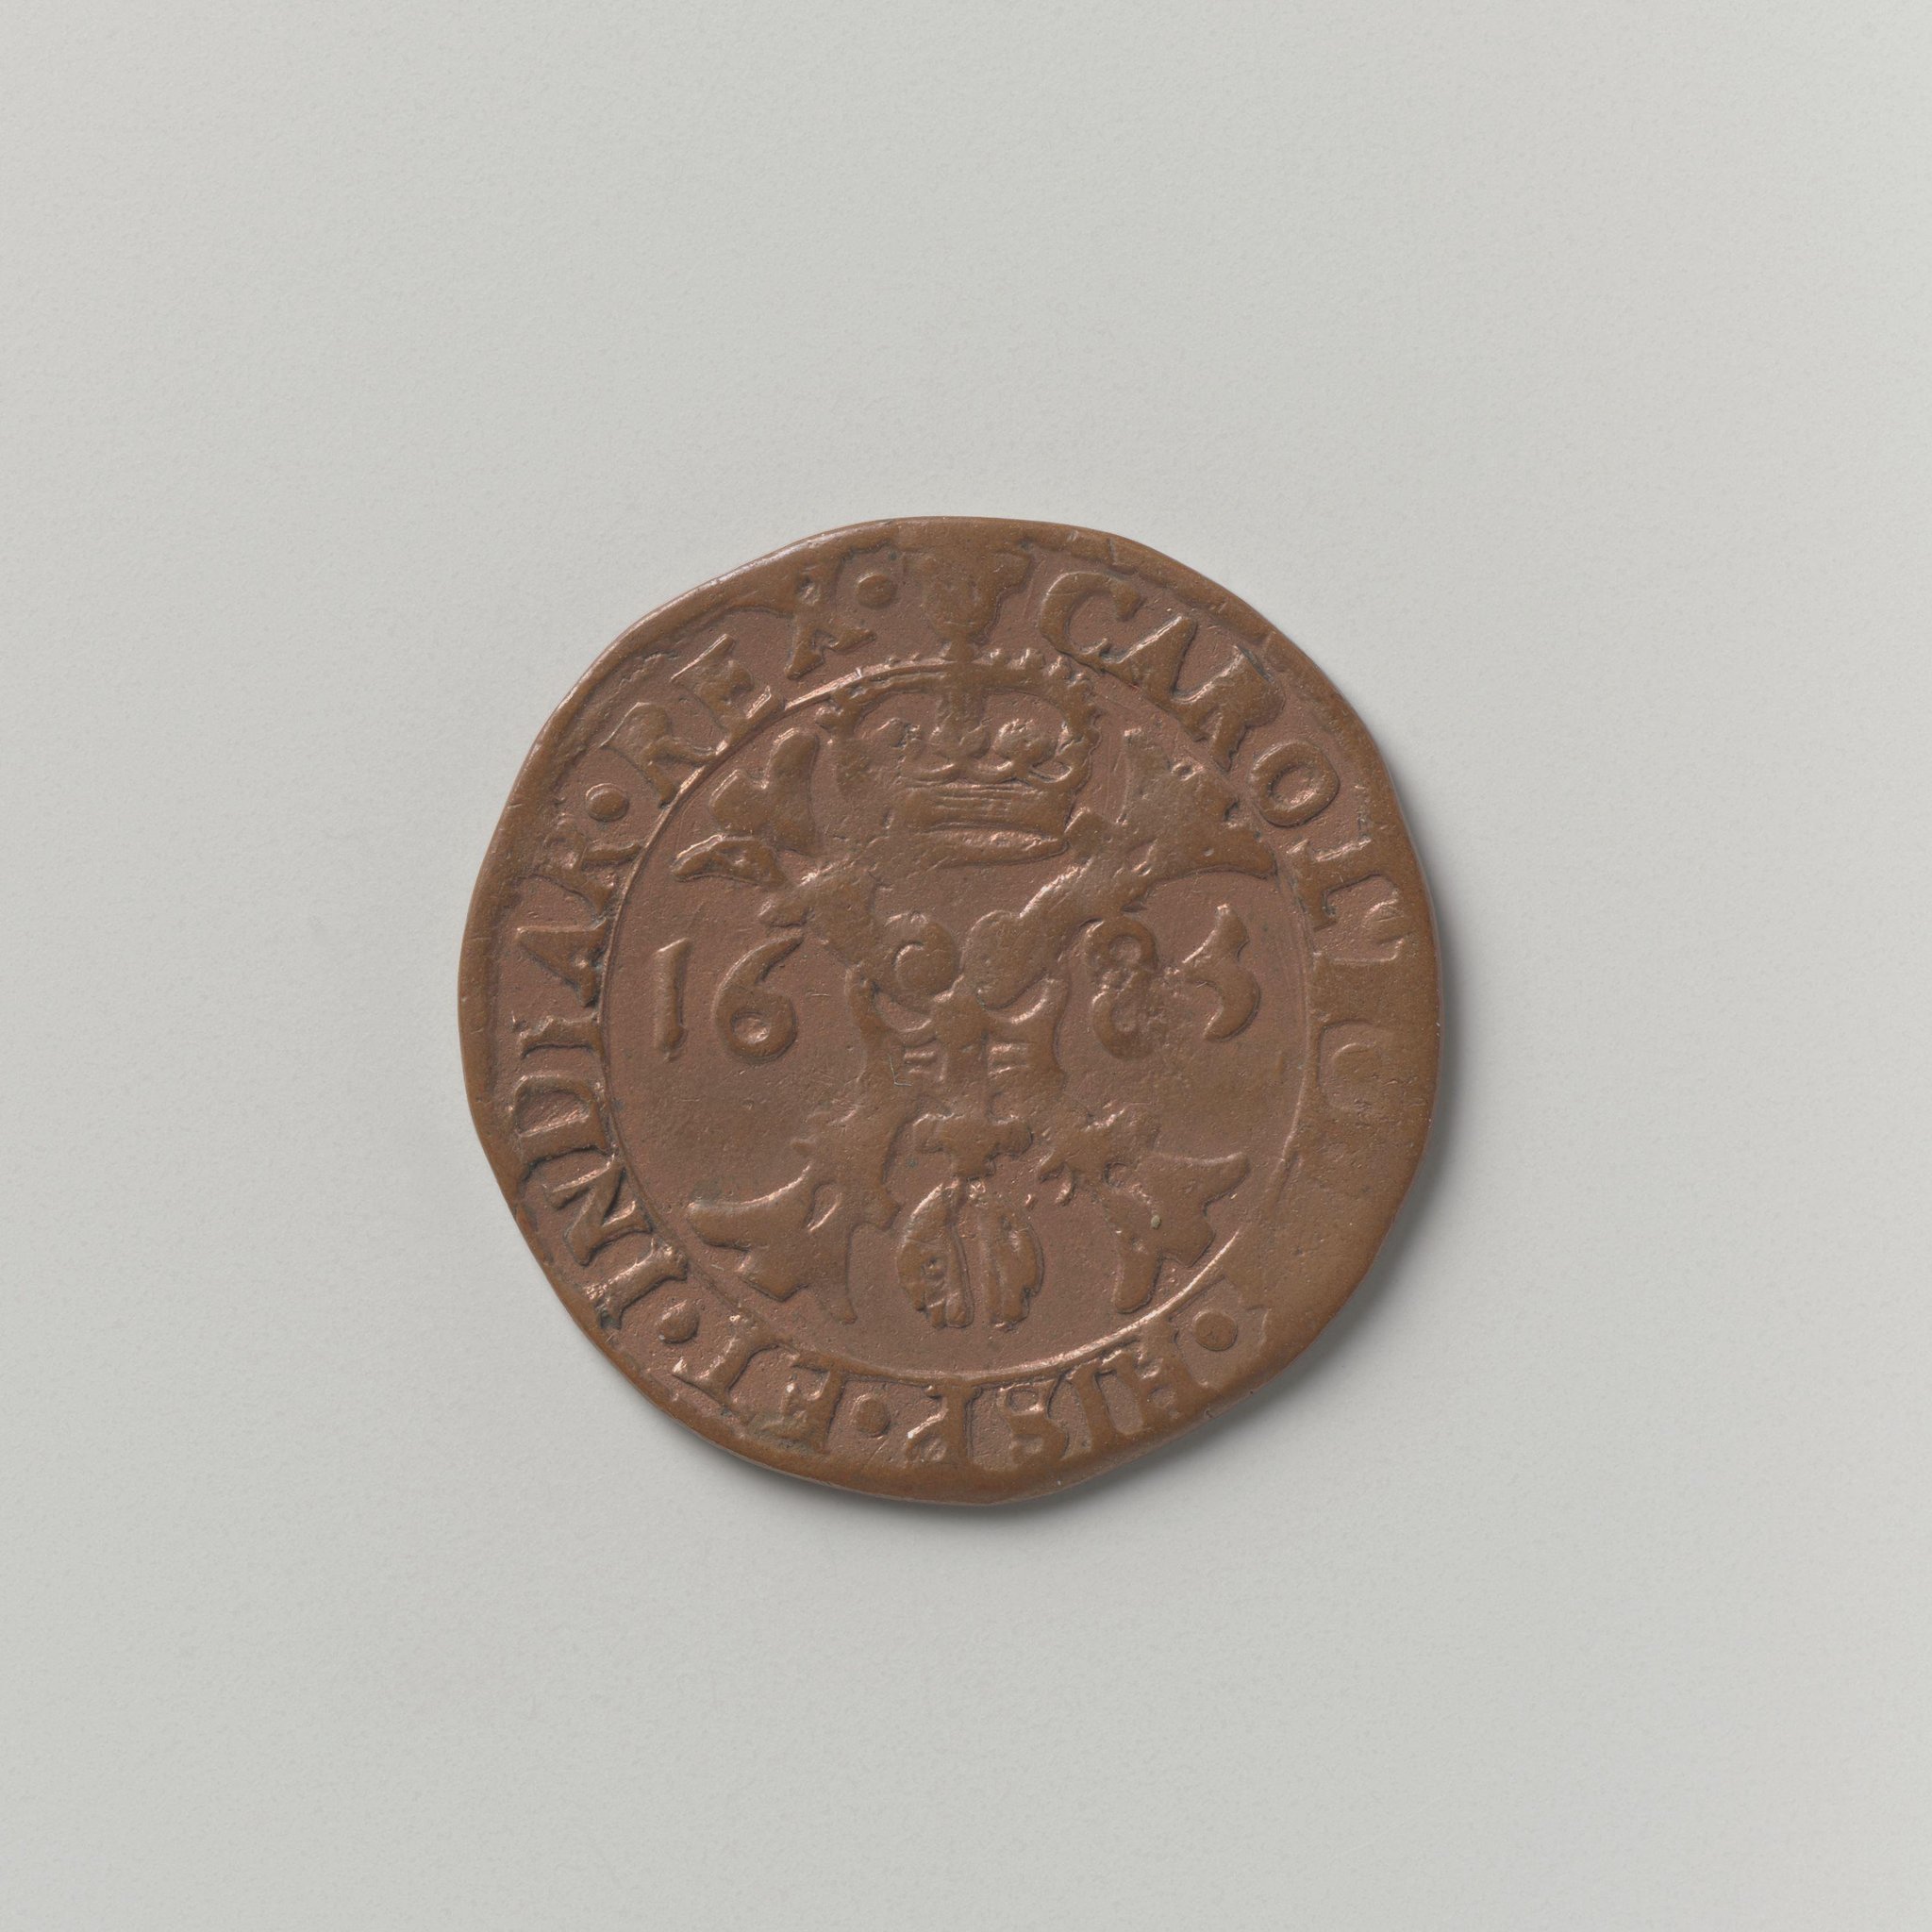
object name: coin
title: Brabant, Karel II, duit,1685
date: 1685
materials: copper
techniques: striking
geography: antwerp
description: Koperen munt. Voorzijde: gekroond versierd samengesteld wapenschild. Hand aan het eind van het omschrift. Keerzijde: tussen jaartal vuurijzer op stokkenkruis Daarboven kroon, daaronder gulden vlies. Hand aan het begin van het omschrift.